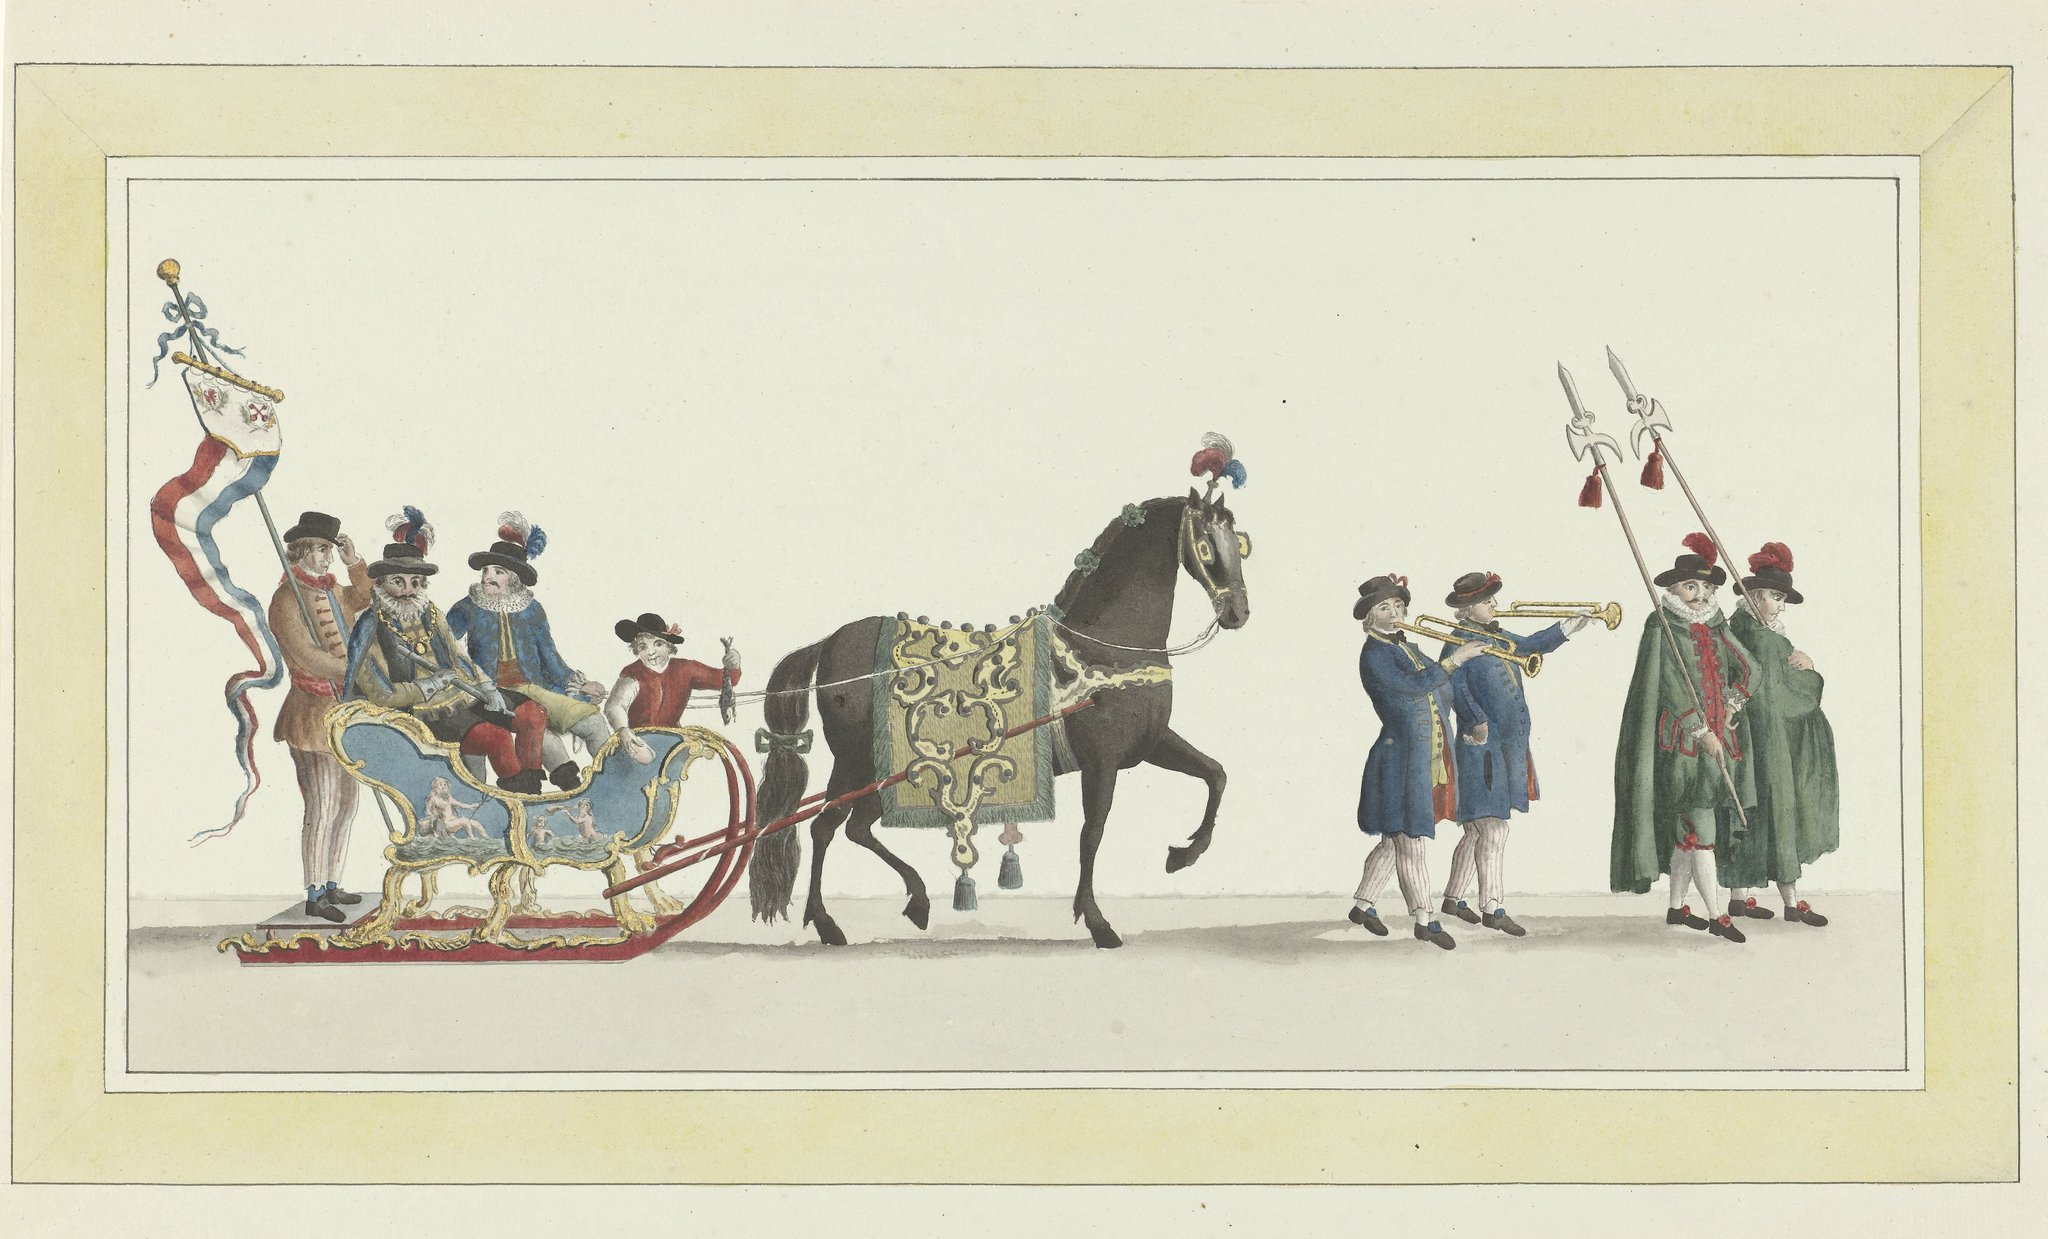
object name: drawing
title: Sledevaart van het Leidse genootschap Veniam Pro Laude in 1776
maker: abraham delfos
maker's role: draughtsman, painter, print maker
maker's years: 1731-1820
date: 1776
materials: paper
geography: northern netherlands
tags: brussels, sledge, sleigh (winter sports), commemoration of the founding of a university, leiden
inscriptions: collector's mark: Lugt 2228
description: De vijfde slede in de optocht. Een slede met Louis de Boisot en een jongen met witbrood en een haring, getrokken door een paard en voorafgegaan door twee muzikanten en twee hellebaardiers. Onderdeel van de reeks van vijftien tekeningen voor de platen van de sledevaart op 24 januari 1776 georganiseerd door het Leidse genootschap Veniam Pro Laude bij gelegenheid van het Tweede Eeuwfeest van het Leids Ontzet (3 oktober 1574) en de oprichting van de Universiteit van Leiden (8 februari 1575).